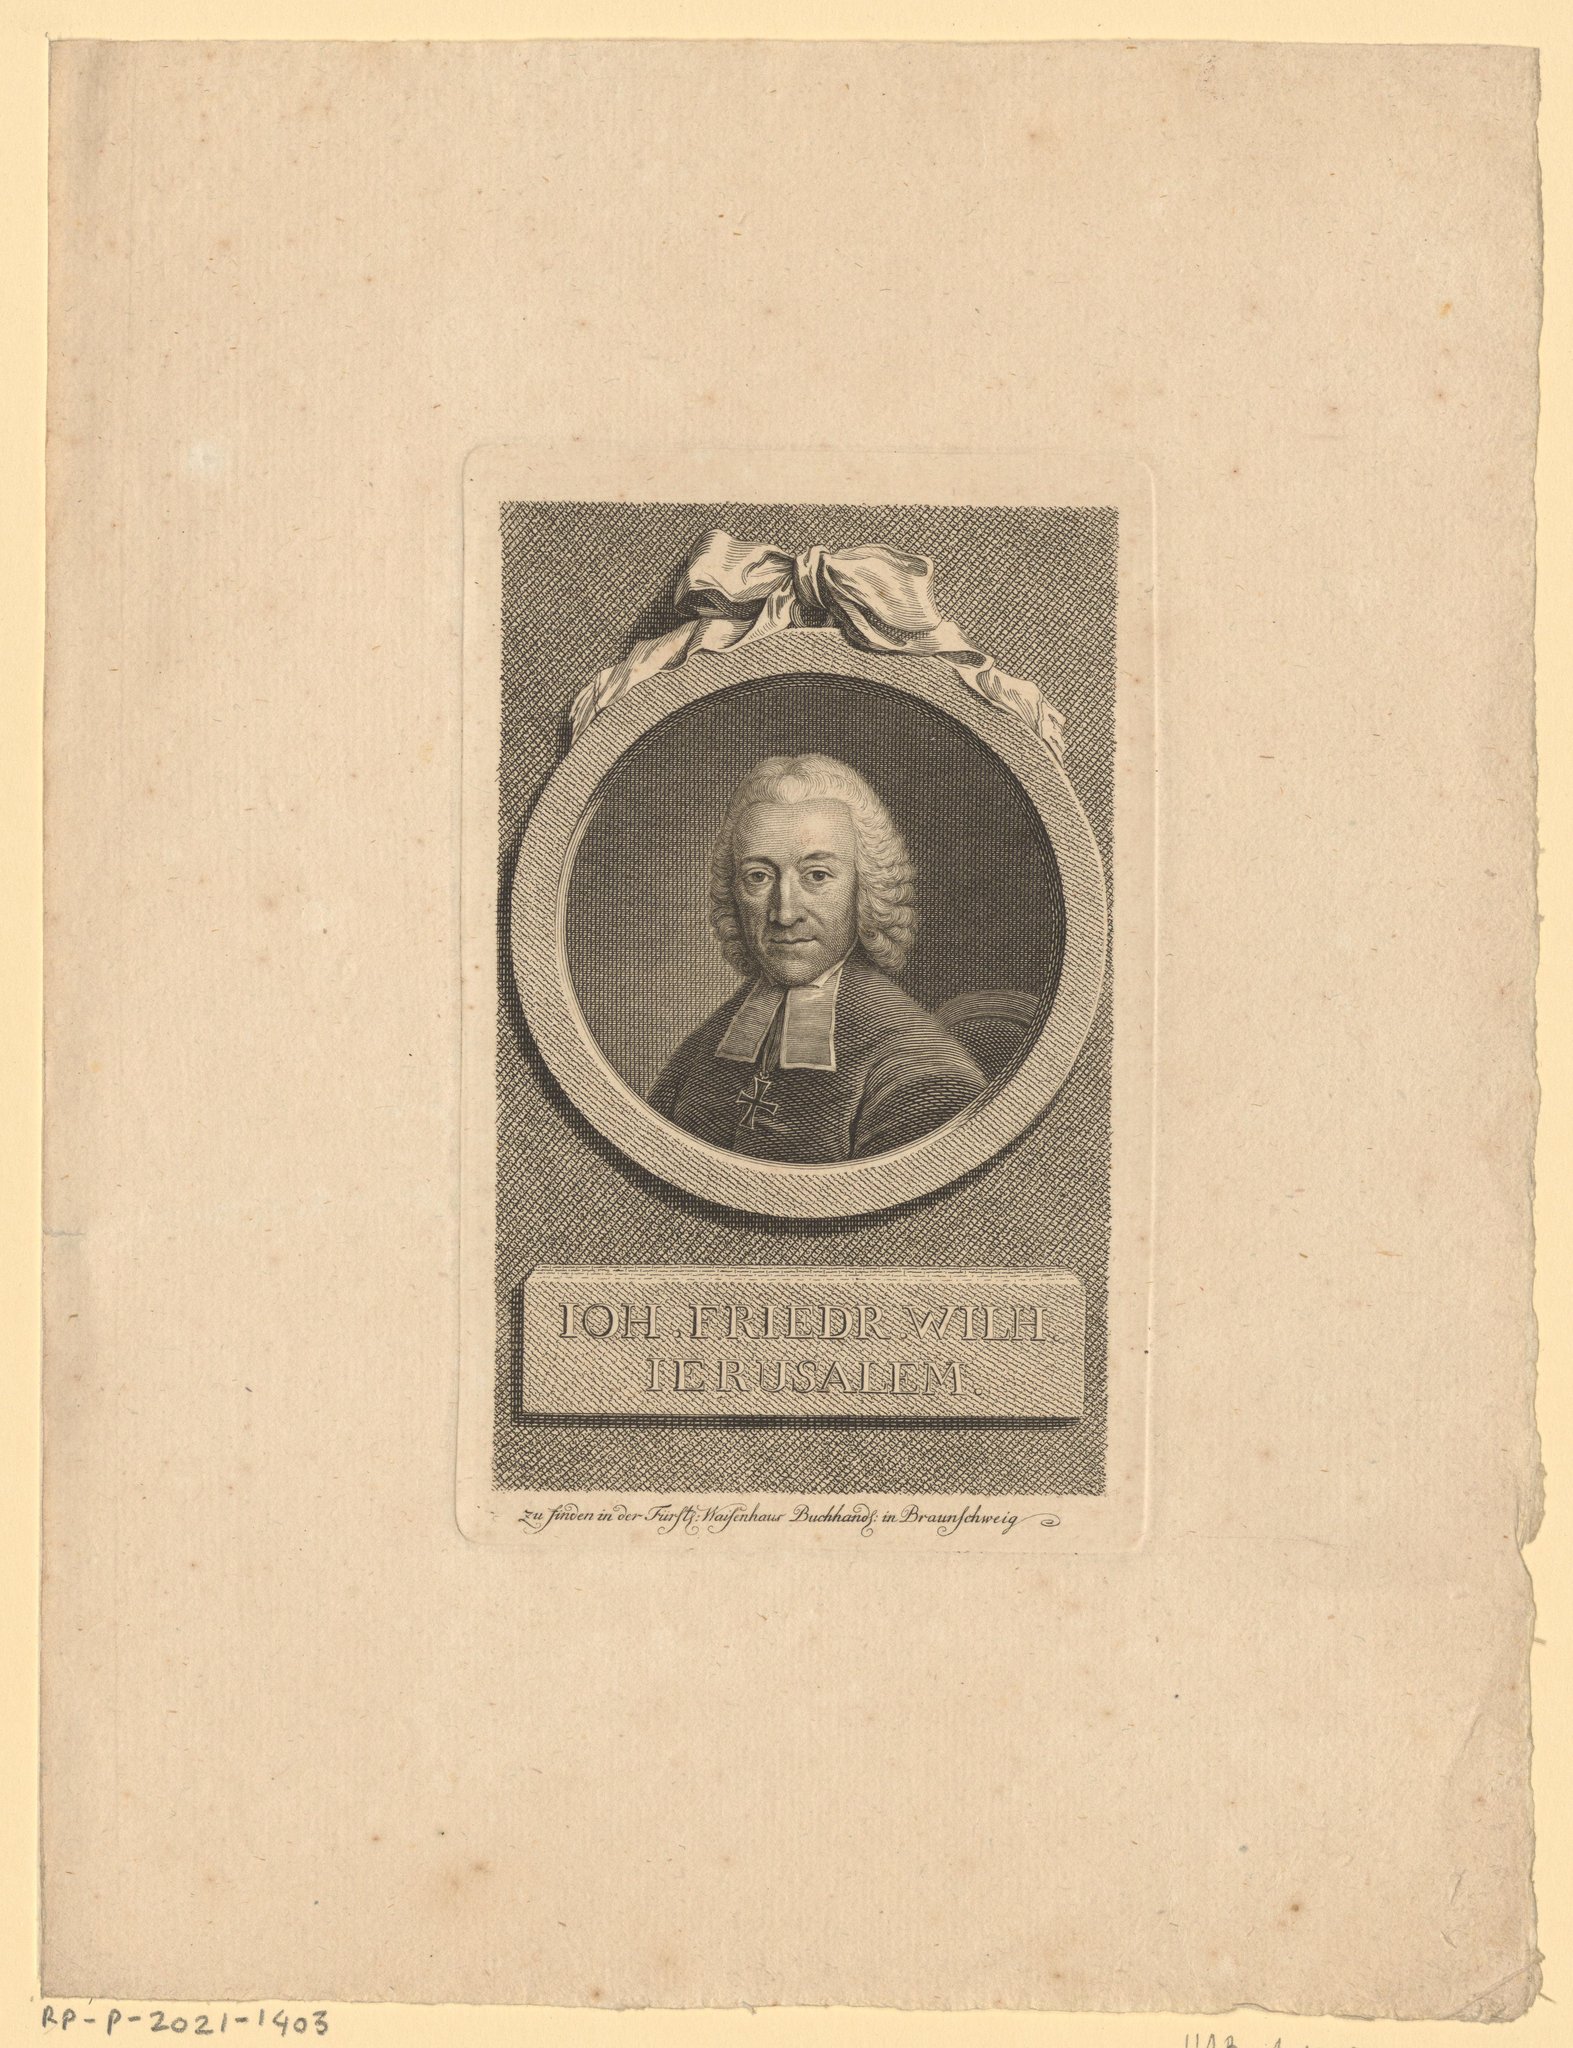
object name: print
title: Portret van Johann Friedrich Wilhelm Jerusalem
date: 1751-1786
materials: paper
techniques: engraving, etching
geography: braunschweig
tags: theologian, historical persons